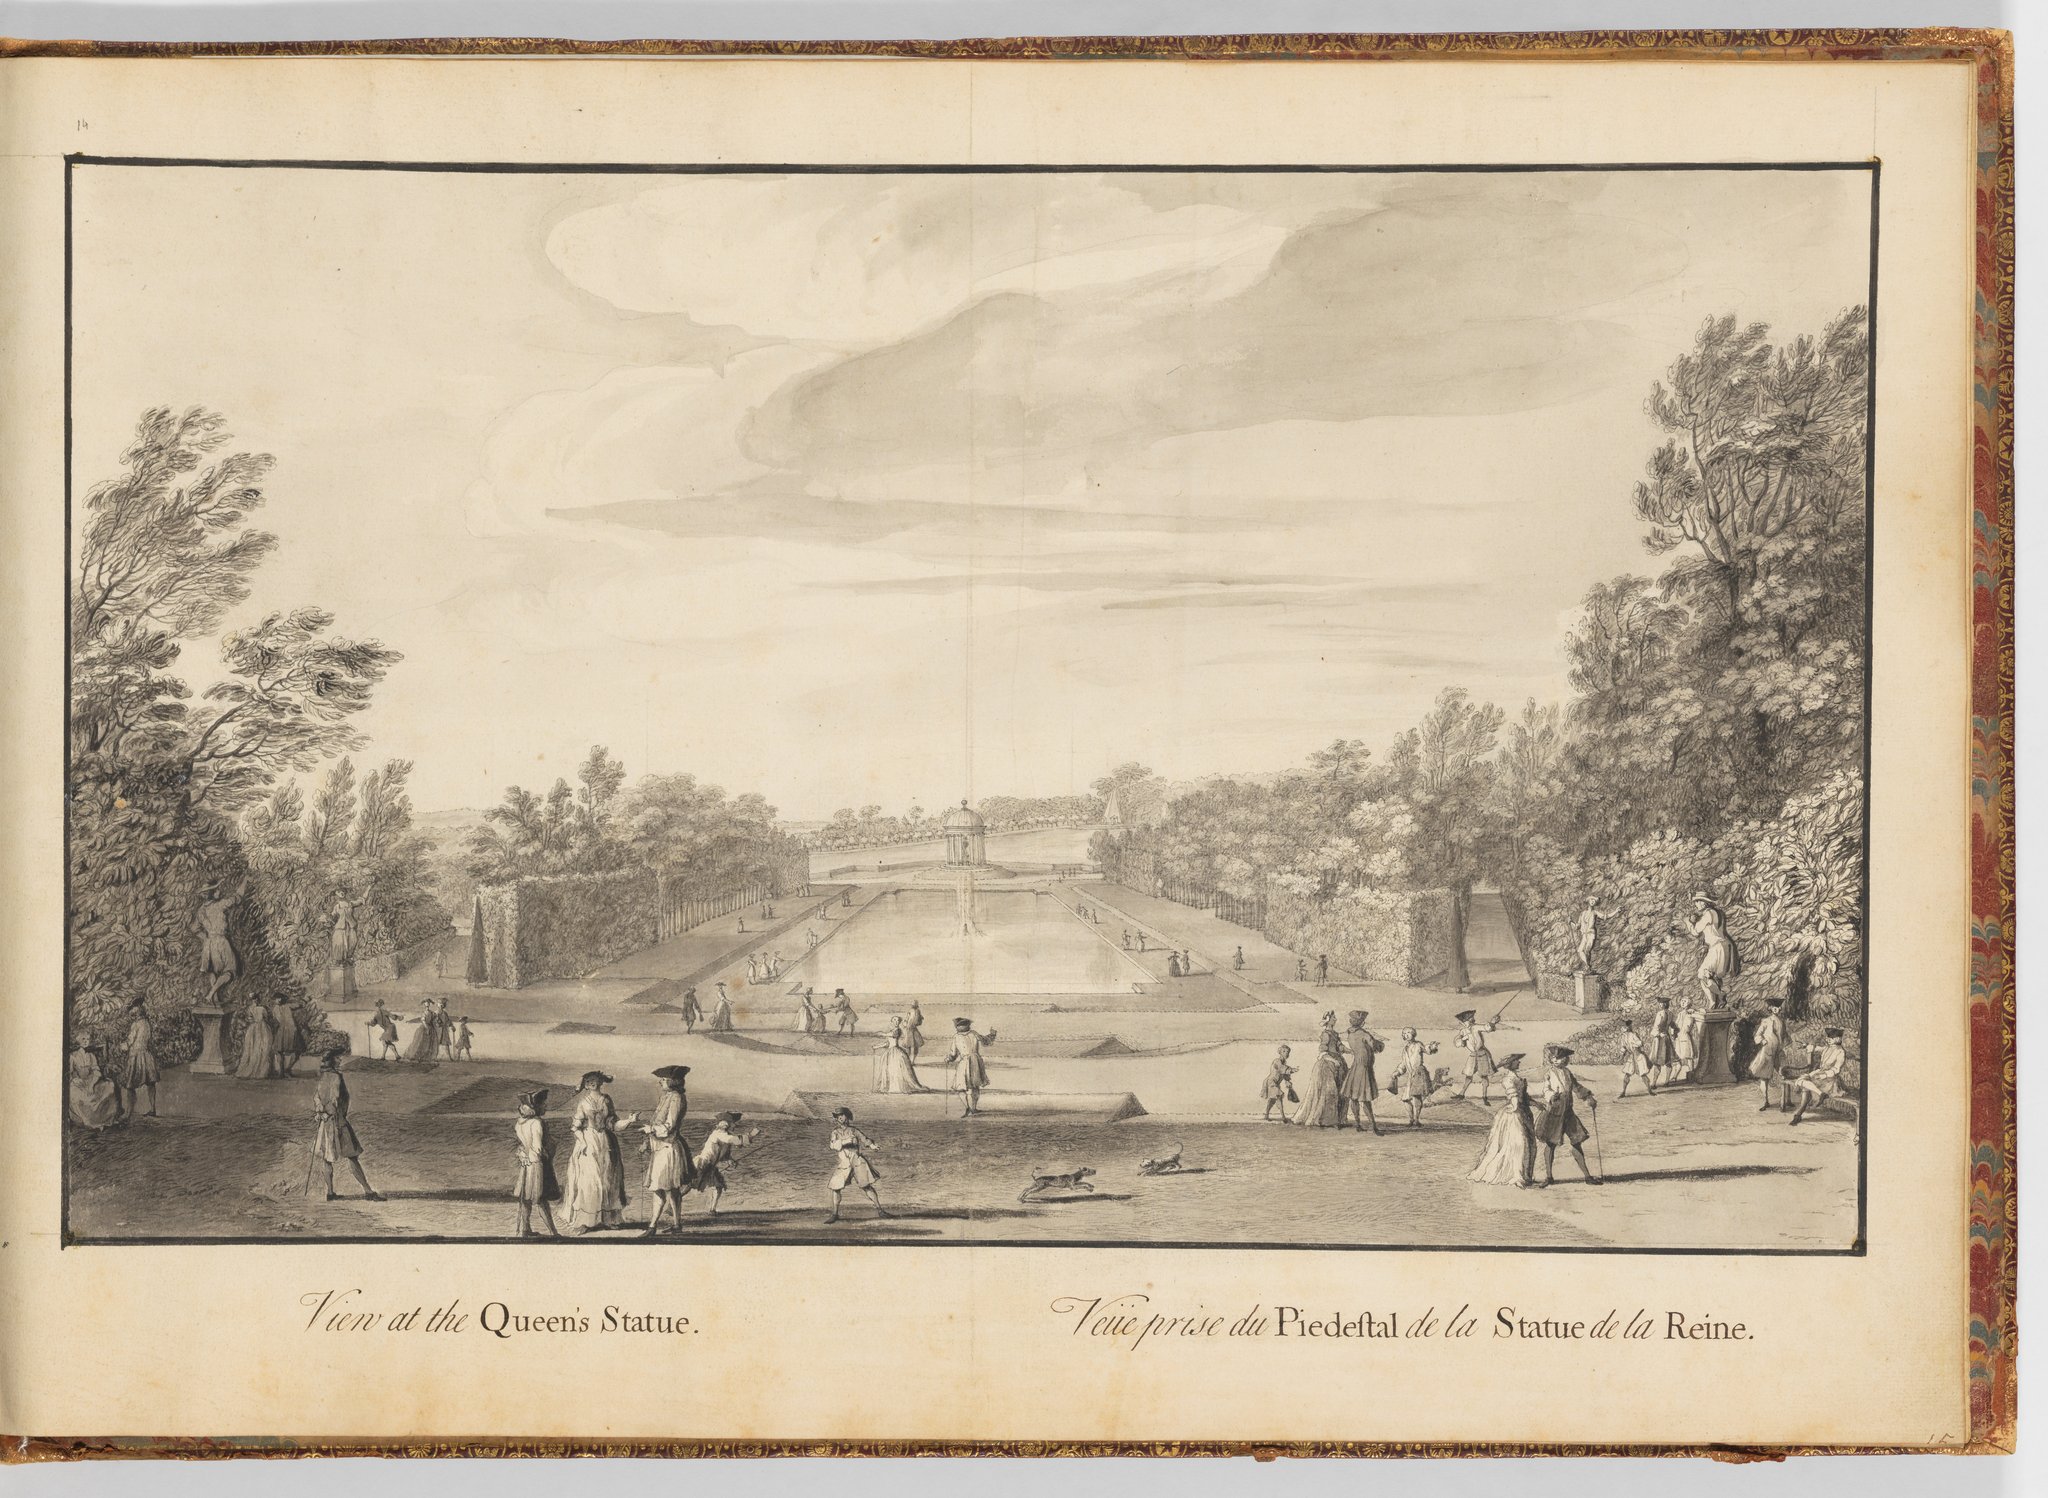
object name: drawing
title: View at the Queen's Statue at Stowe, Buckinghamshire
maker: jacques rigaud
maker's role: artist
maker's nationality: french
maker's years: 1681-1754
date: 1733-1734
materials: ink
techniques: brush, pen, wash